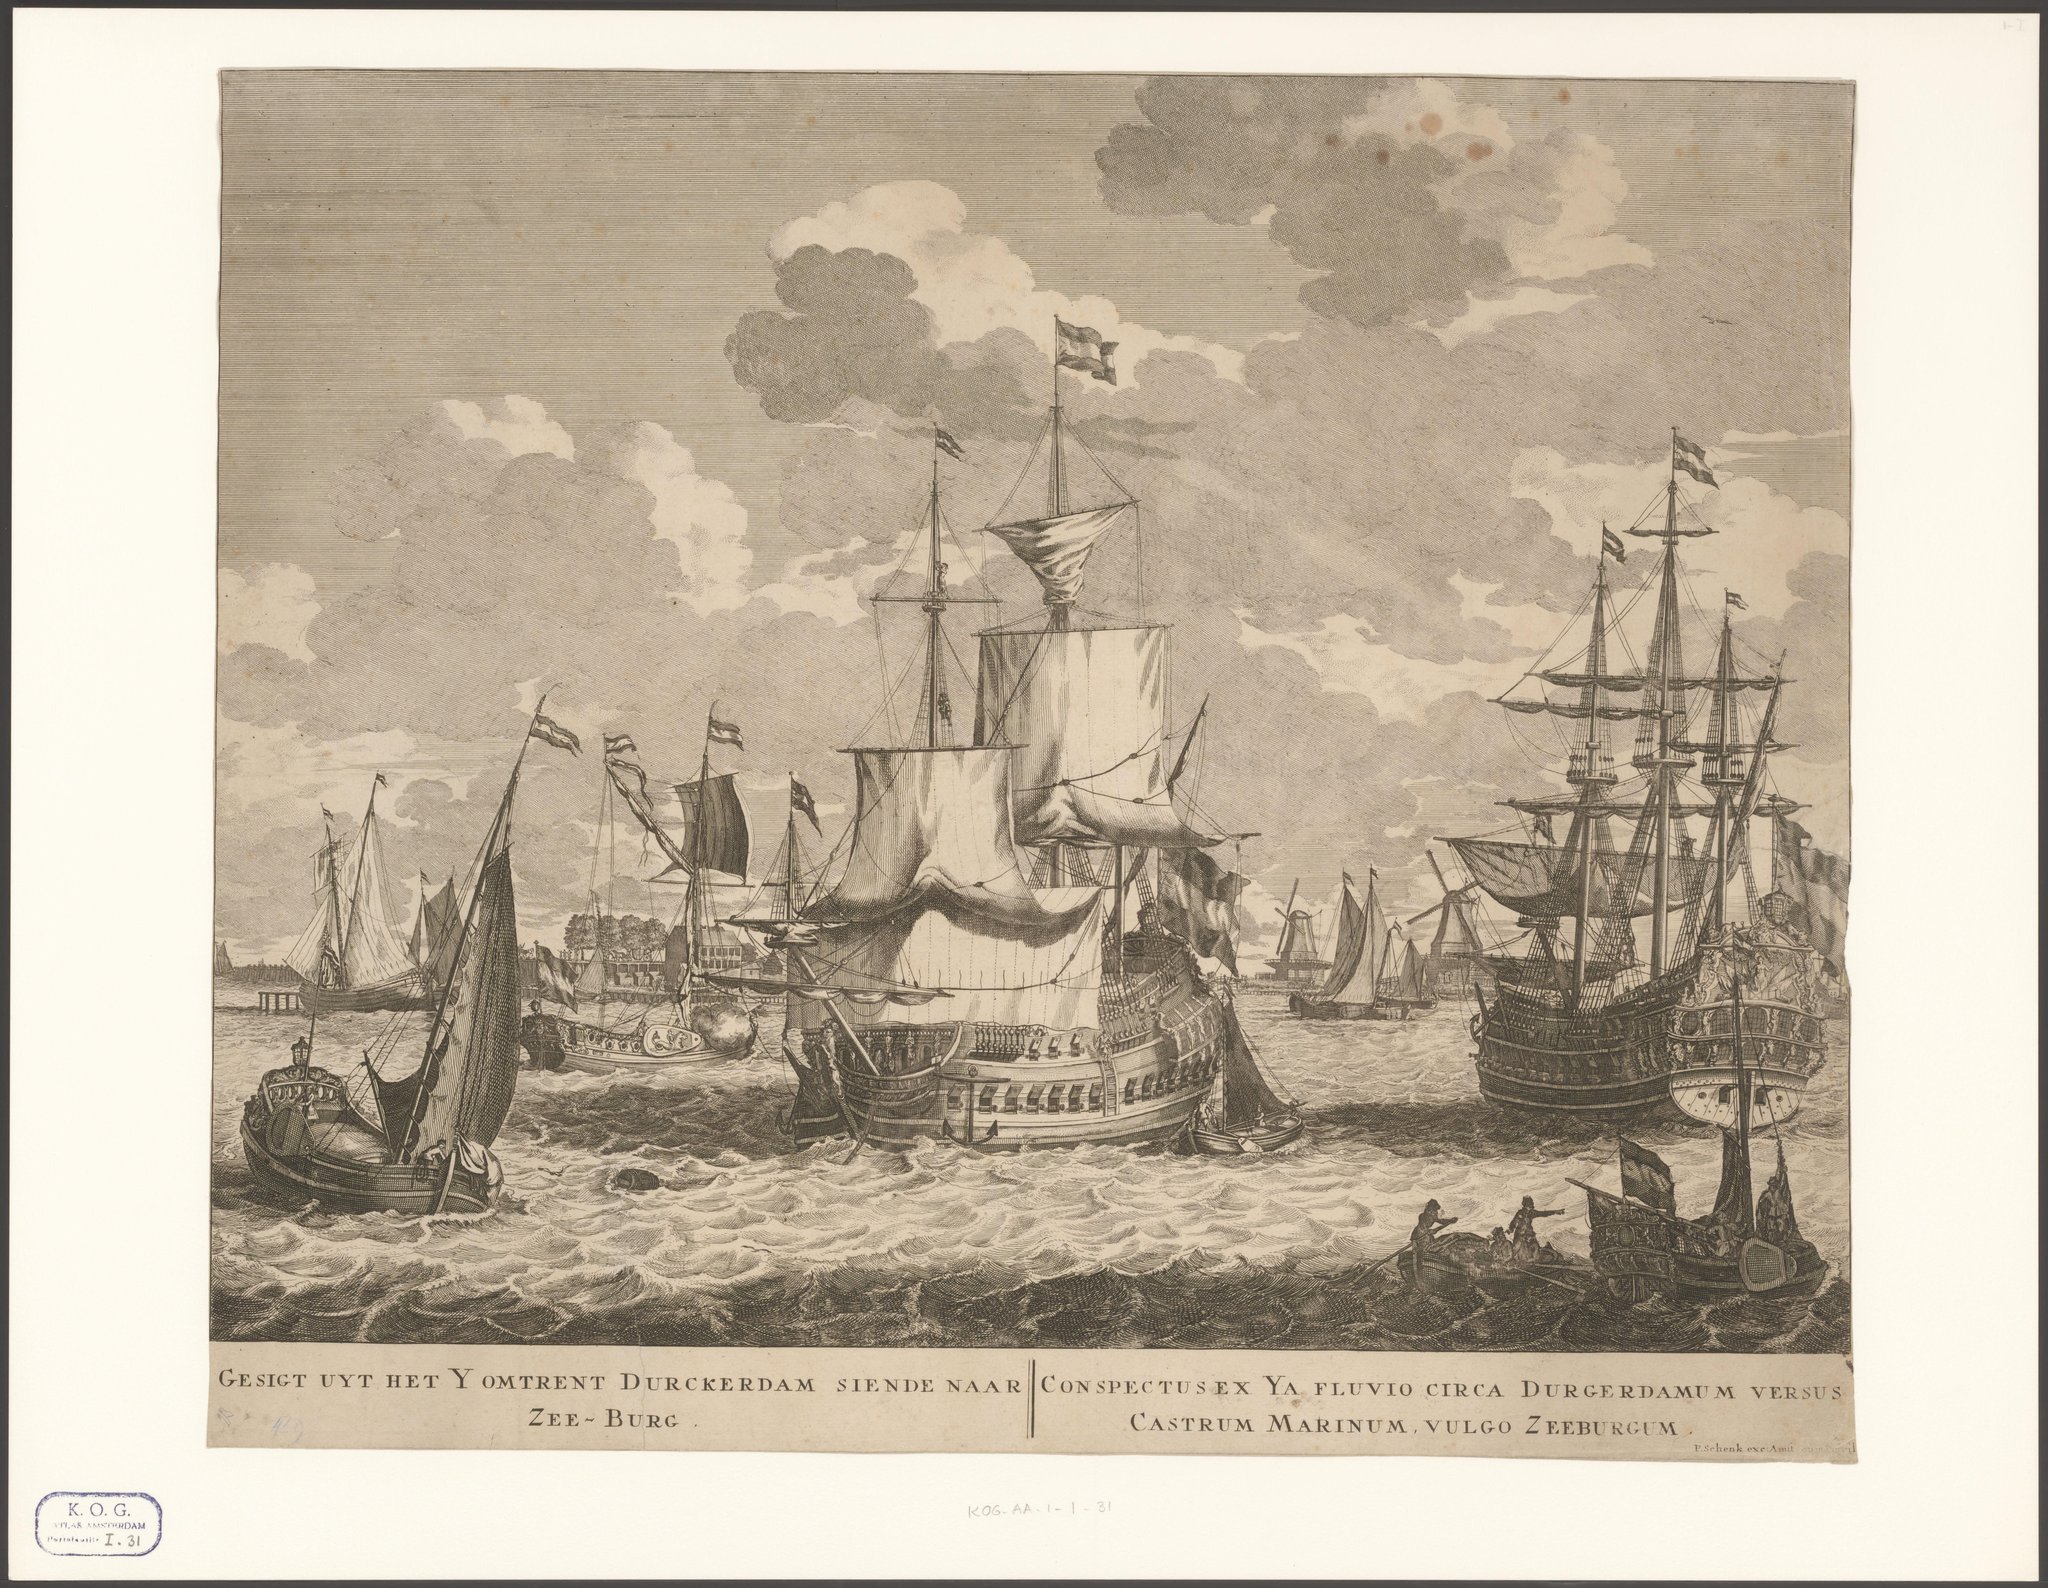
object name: print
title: Gesigt uyt het Y omtrent Durckerdam siende naar Zee-Burg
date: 1695-1711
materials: paper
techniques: etching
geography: amsterdam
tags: city-view in general; 'veduta', river, windmill in landscape, ships (in general) - cc - more than one ship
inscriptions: collector's mark: ‘I.31’ Lugt 1641b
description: Onderwerpsrubriek binnen de Atlas Amsterdam: Gezichten van den geheelen IJkant der Stad.